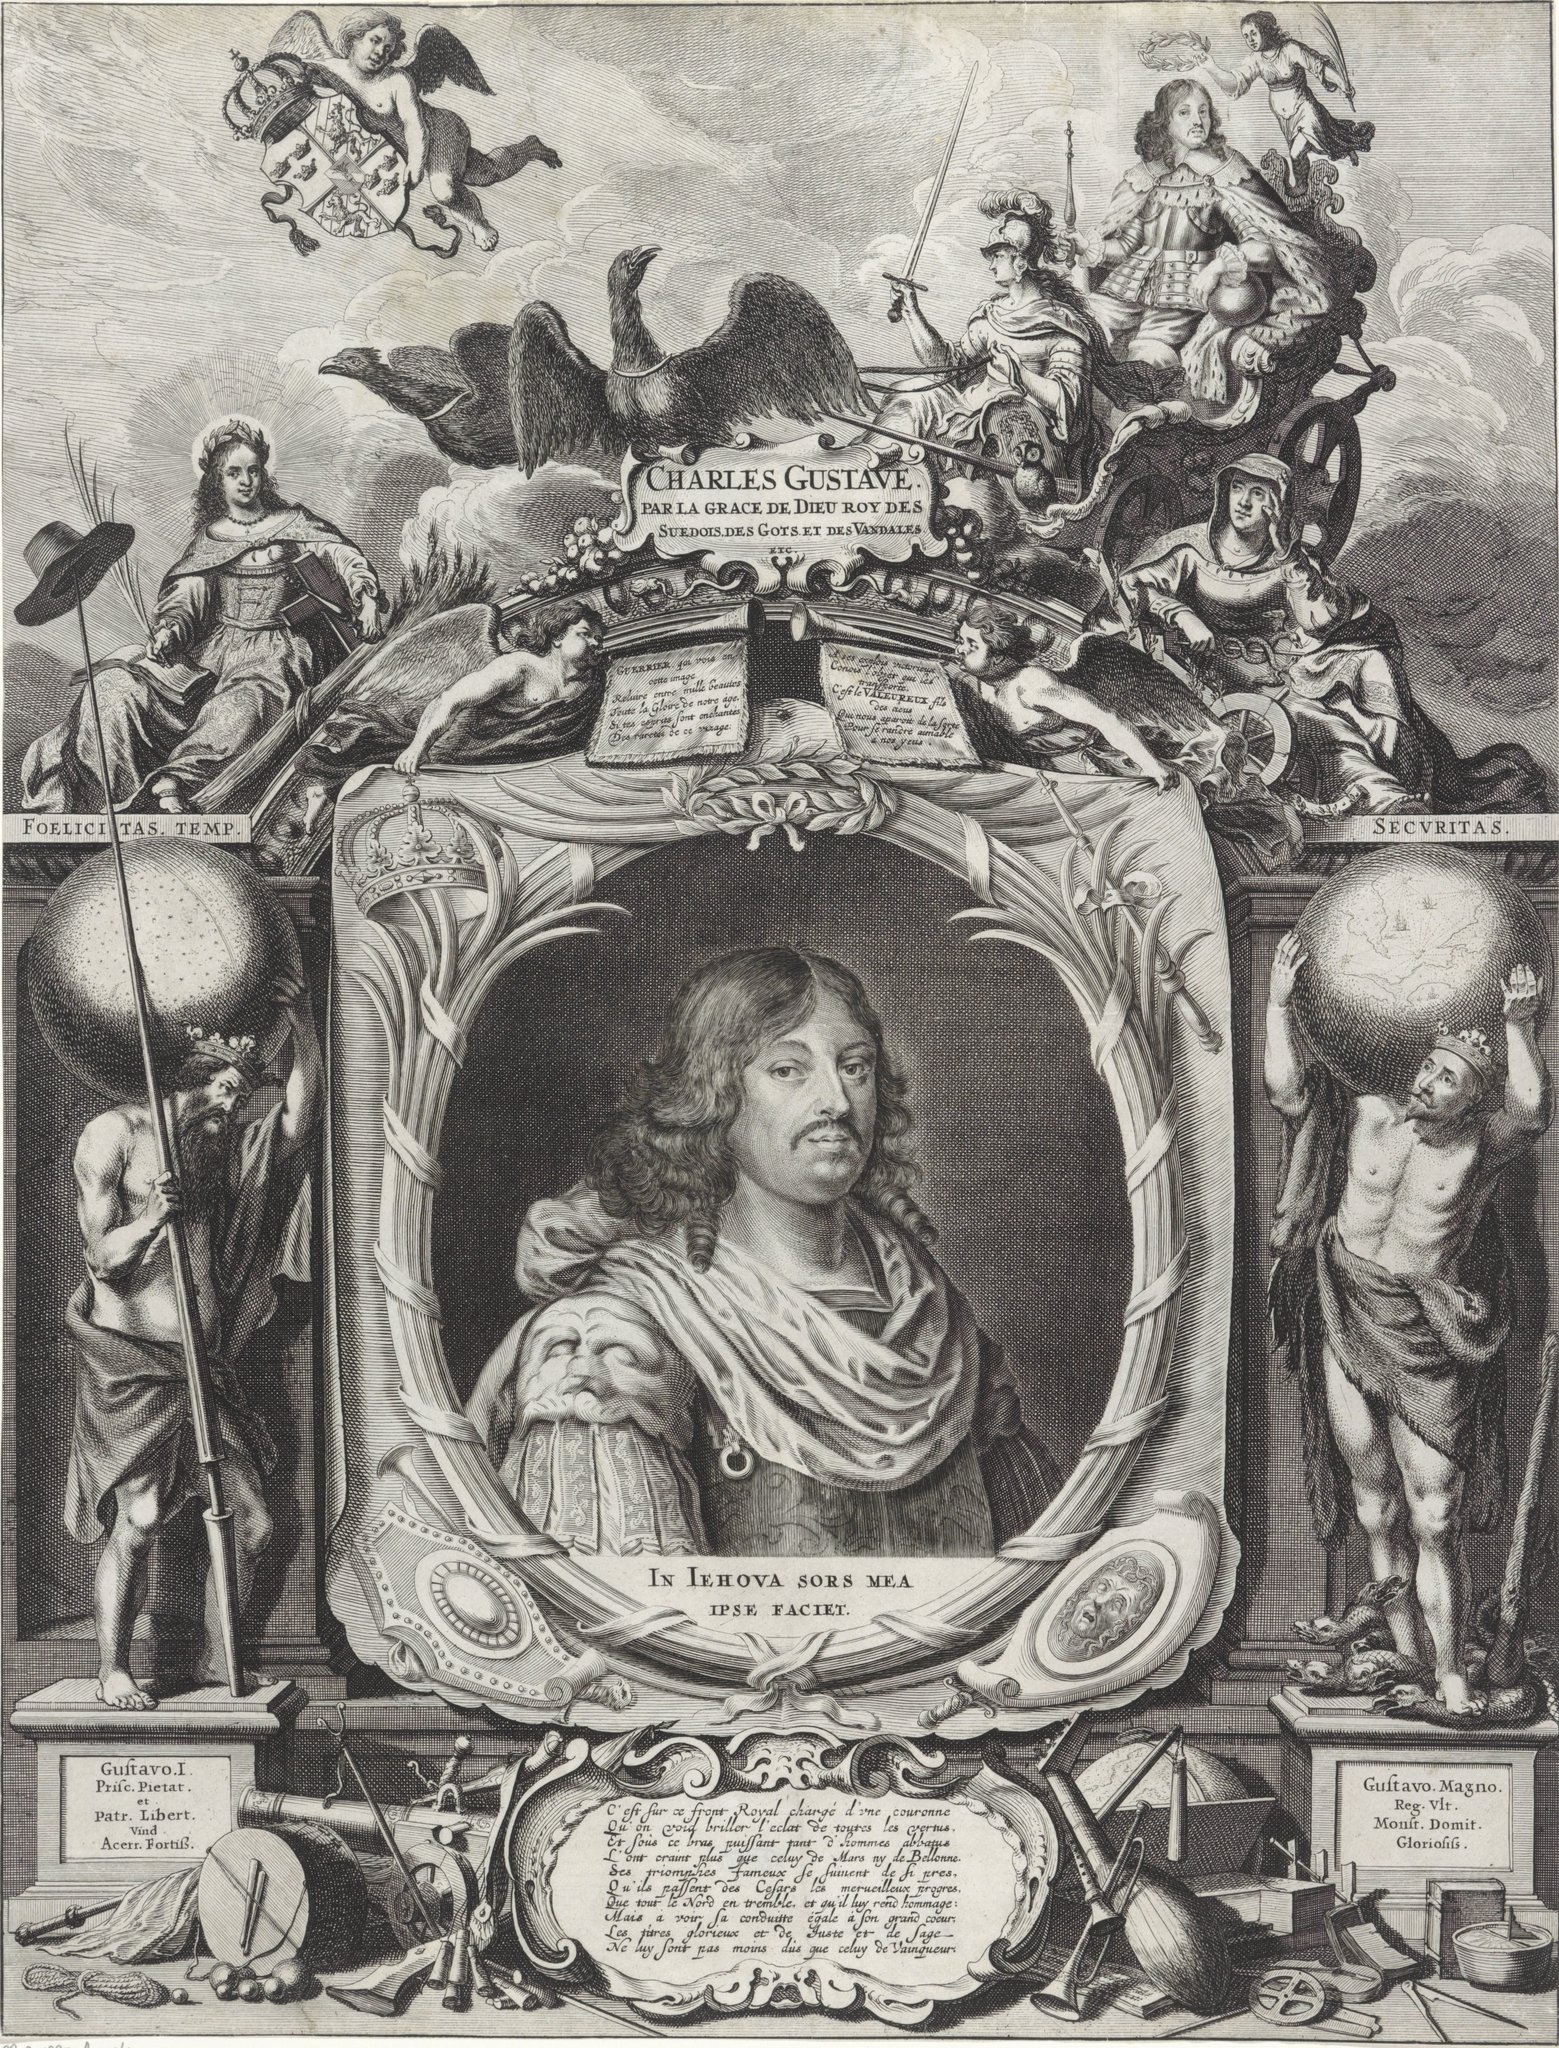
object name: print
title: Portret van koning Karel Gustaaf van Zweden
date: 1654-1660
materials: paper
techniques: engraving, etching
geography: amsterdam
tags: faith, 'fides'; 'fede', 'fede catholica', 'fede christiana', 'fede christiana catholica' (ripa) ~ one of the three theological virtues, (story of) minerva (pallas, athena), globe, freedom, liberty; 'libertà' (ripa) (+ symbolical representation of concept)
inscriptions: collector's mark: Lugt 2228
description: Portret van Karel Gustaaf, koning van Zweden. Bovenaan op de wolken Karel Gustaaf gezeten in een koets met een scepter in zijn hand. De koets wordt bestuurd door Minerva en getrokken door twee adelaars. Links van het portret koning Gustaaf I van Zweden, die een hemelglobe tilt en een vrijheidslans in de hand houdt. Rechts van het portret staat Gustaaf II Adolf, koning van Zweden, gekleed als Hercules en met de globe op zijn schouders, terwijl hij slangen vertrapt. Boven op het lijstwerk zit links Geloof. Rechts zit een allegorische figuur met een caduceus en een roer.